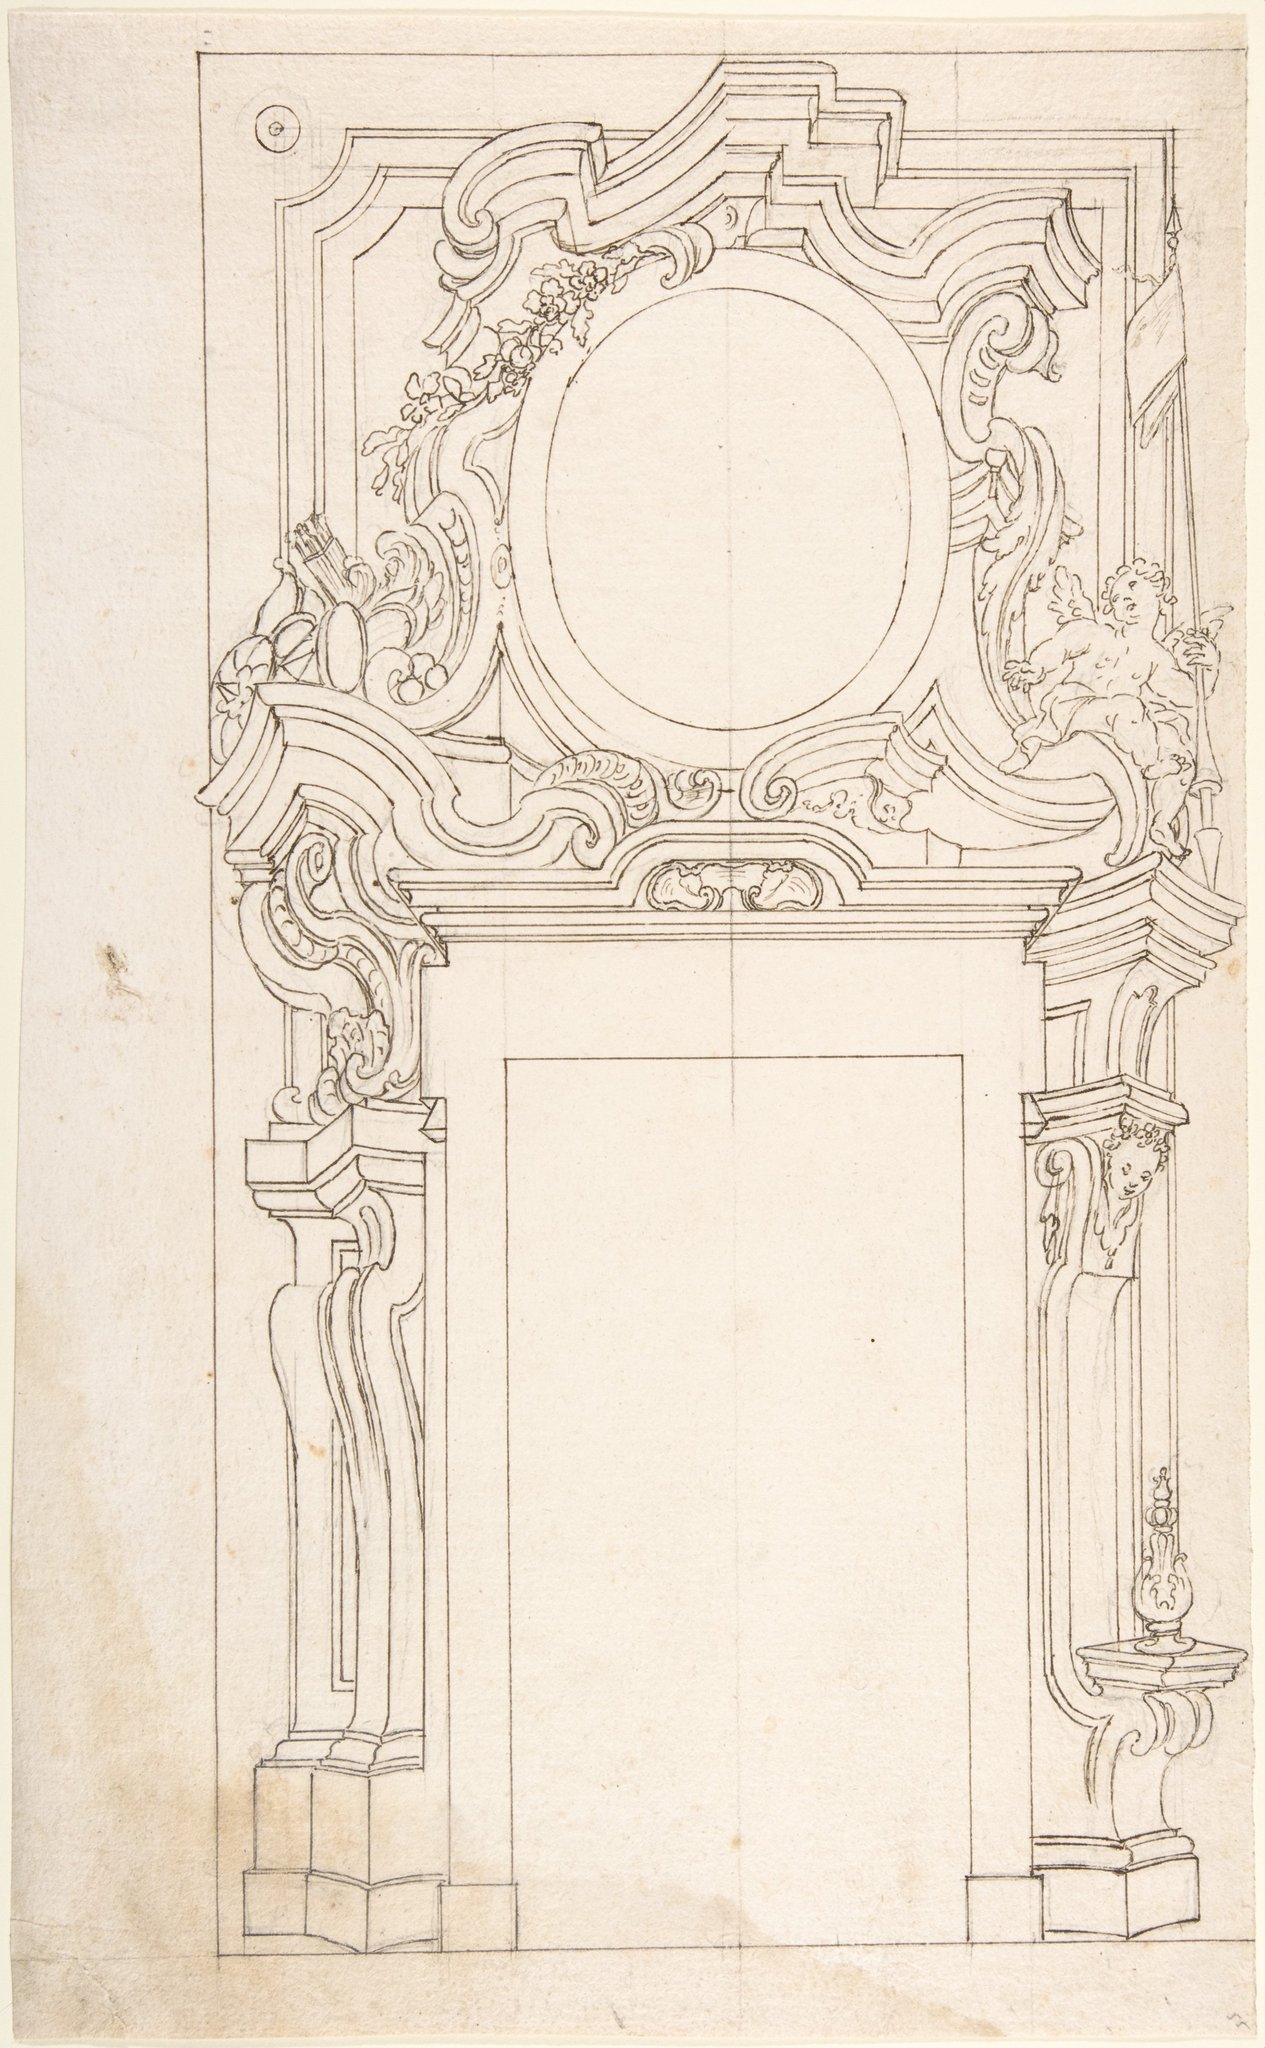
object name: drawing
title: Architectural project for door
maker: anonymous, italian, piedmontese, 18th century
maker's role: artist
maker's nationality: italian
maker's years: 1700-1800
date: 1700-1780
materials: ink, drawing material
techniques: pen